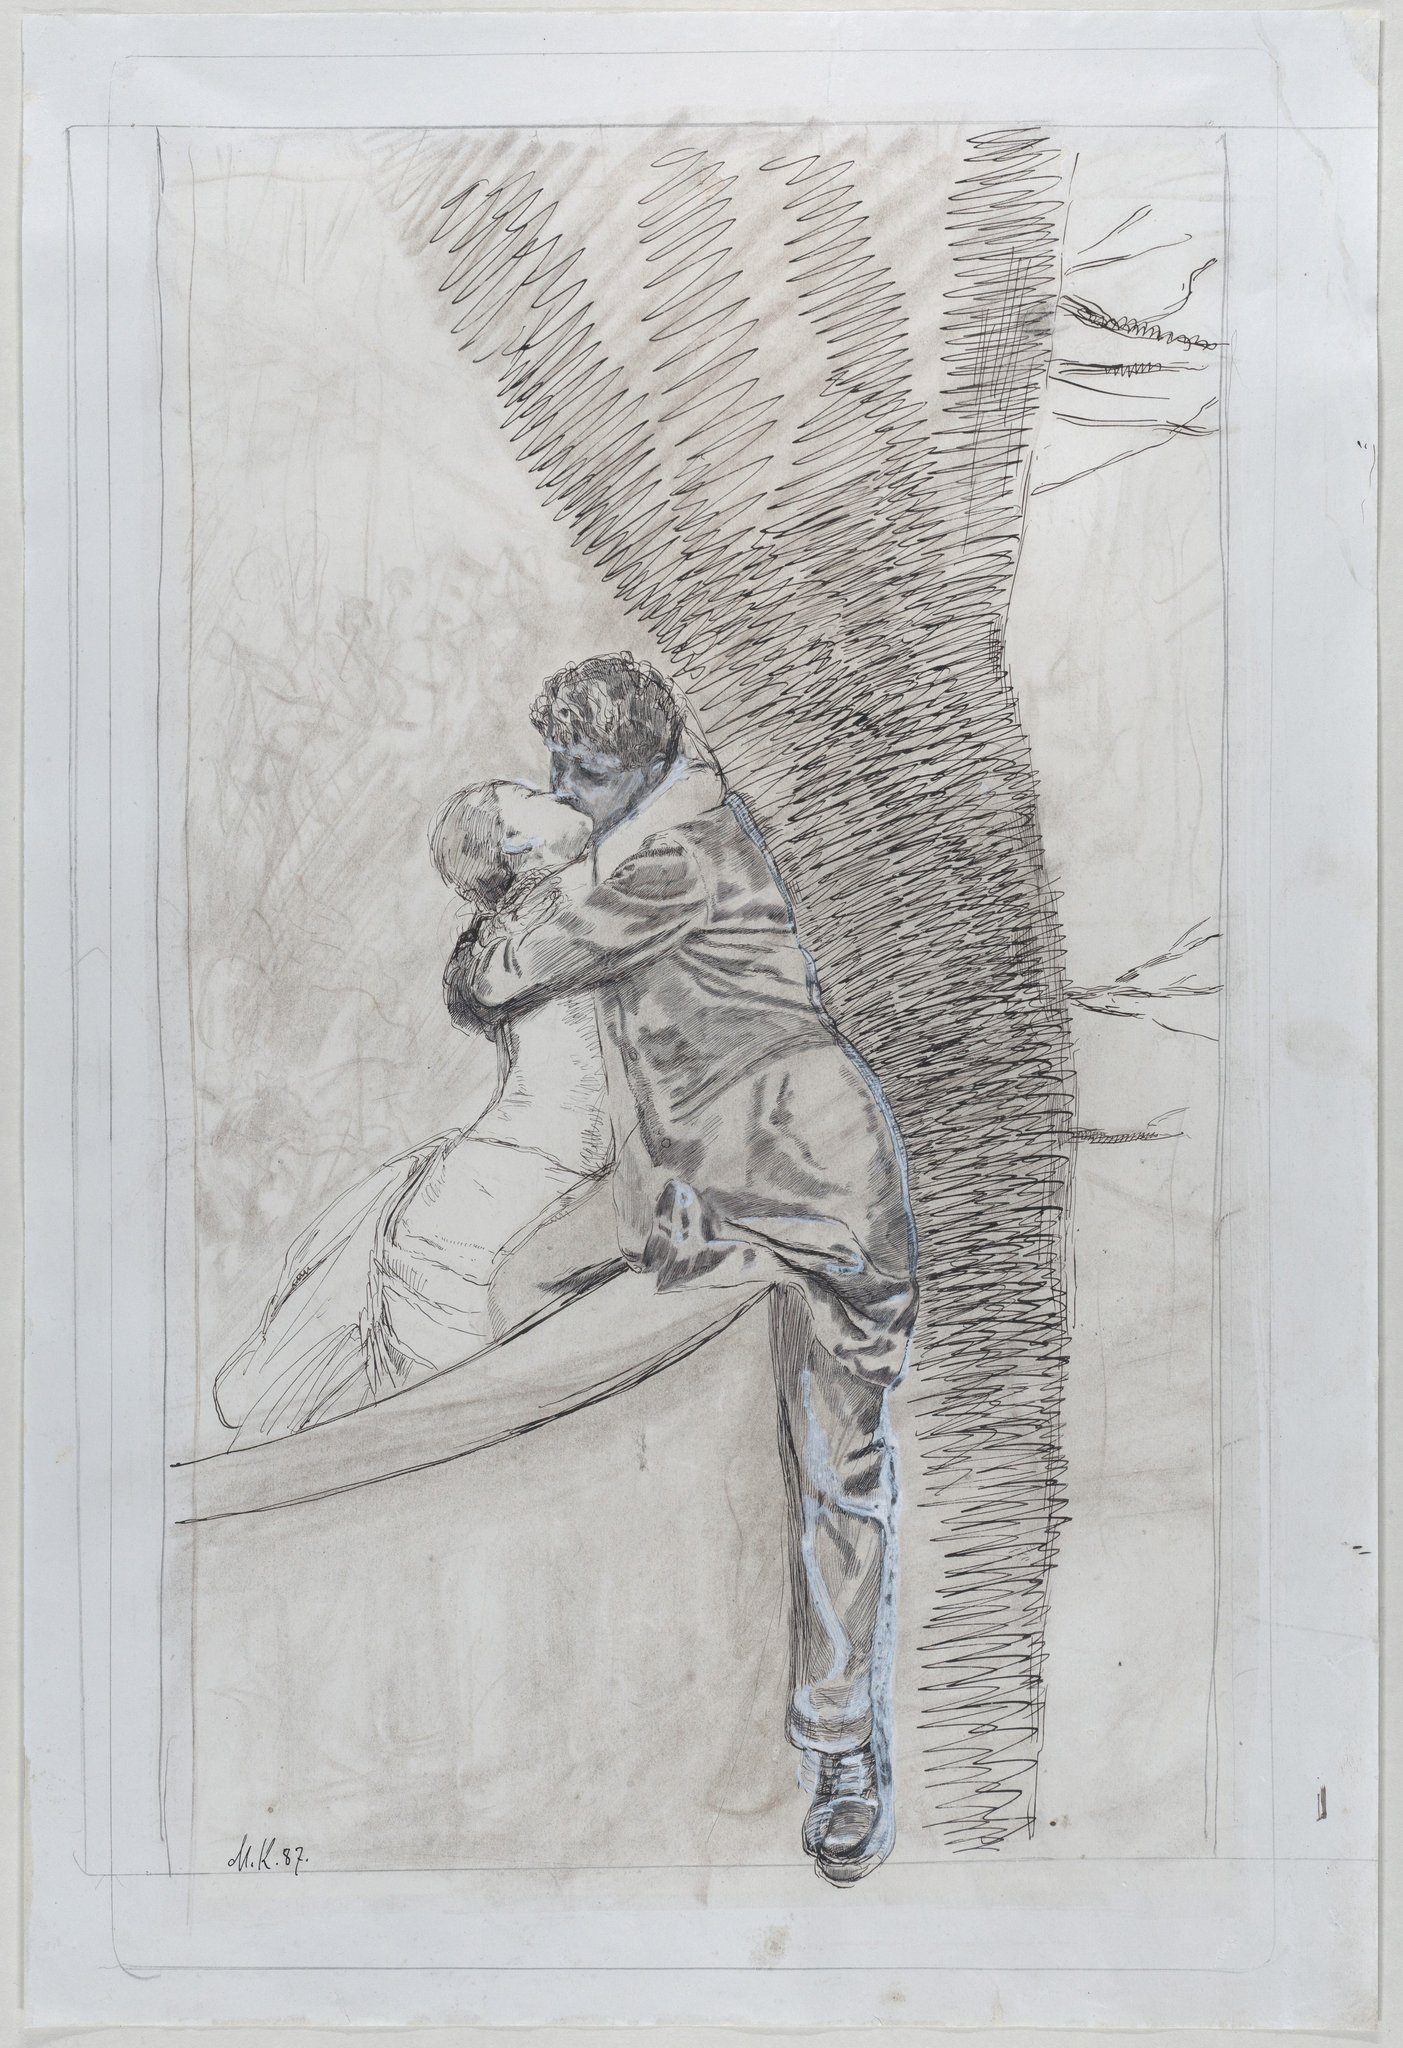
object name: drawing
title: In the Park, from "A Love (Opus X)"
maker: max klinger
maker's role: artist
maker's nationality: german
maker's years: 1857-1920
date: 1887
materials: paint, chalk, ink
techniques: heightening, pen